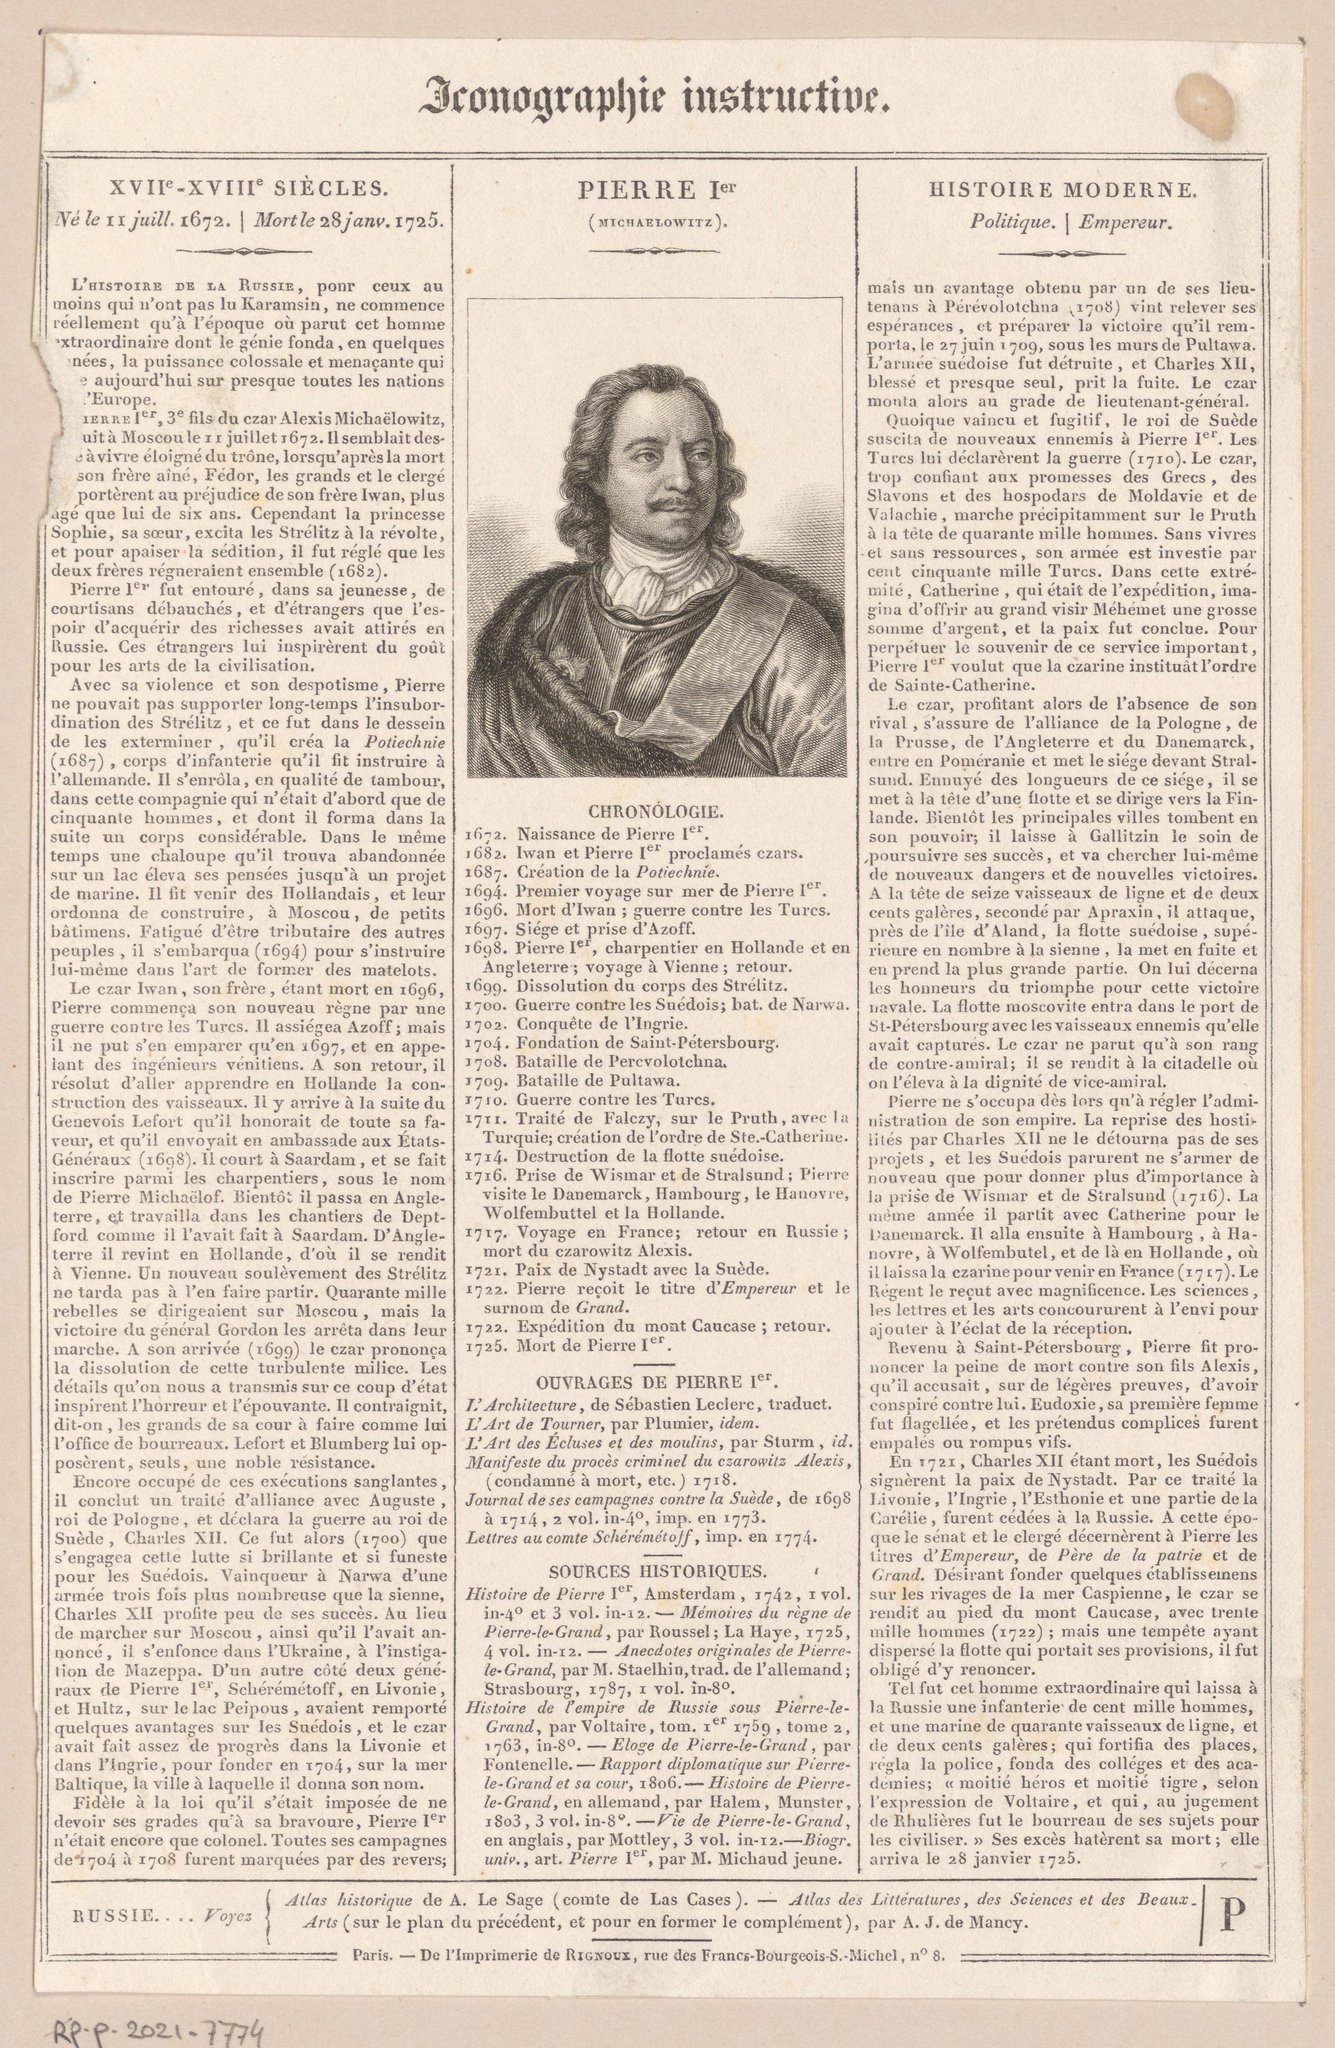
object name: print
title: Historische portrettengalerij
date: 1839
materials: paper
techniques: letterpress printing, engraving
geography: paris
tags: peter i de grote (tsaar van rusland), adult man, historical persons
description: Prent uit: Fliniaux, A. Galerie historique, collection de 200 portraits des personnages les plus célèbres de l'histoire moderne. Parijs: Bénard, 1839.